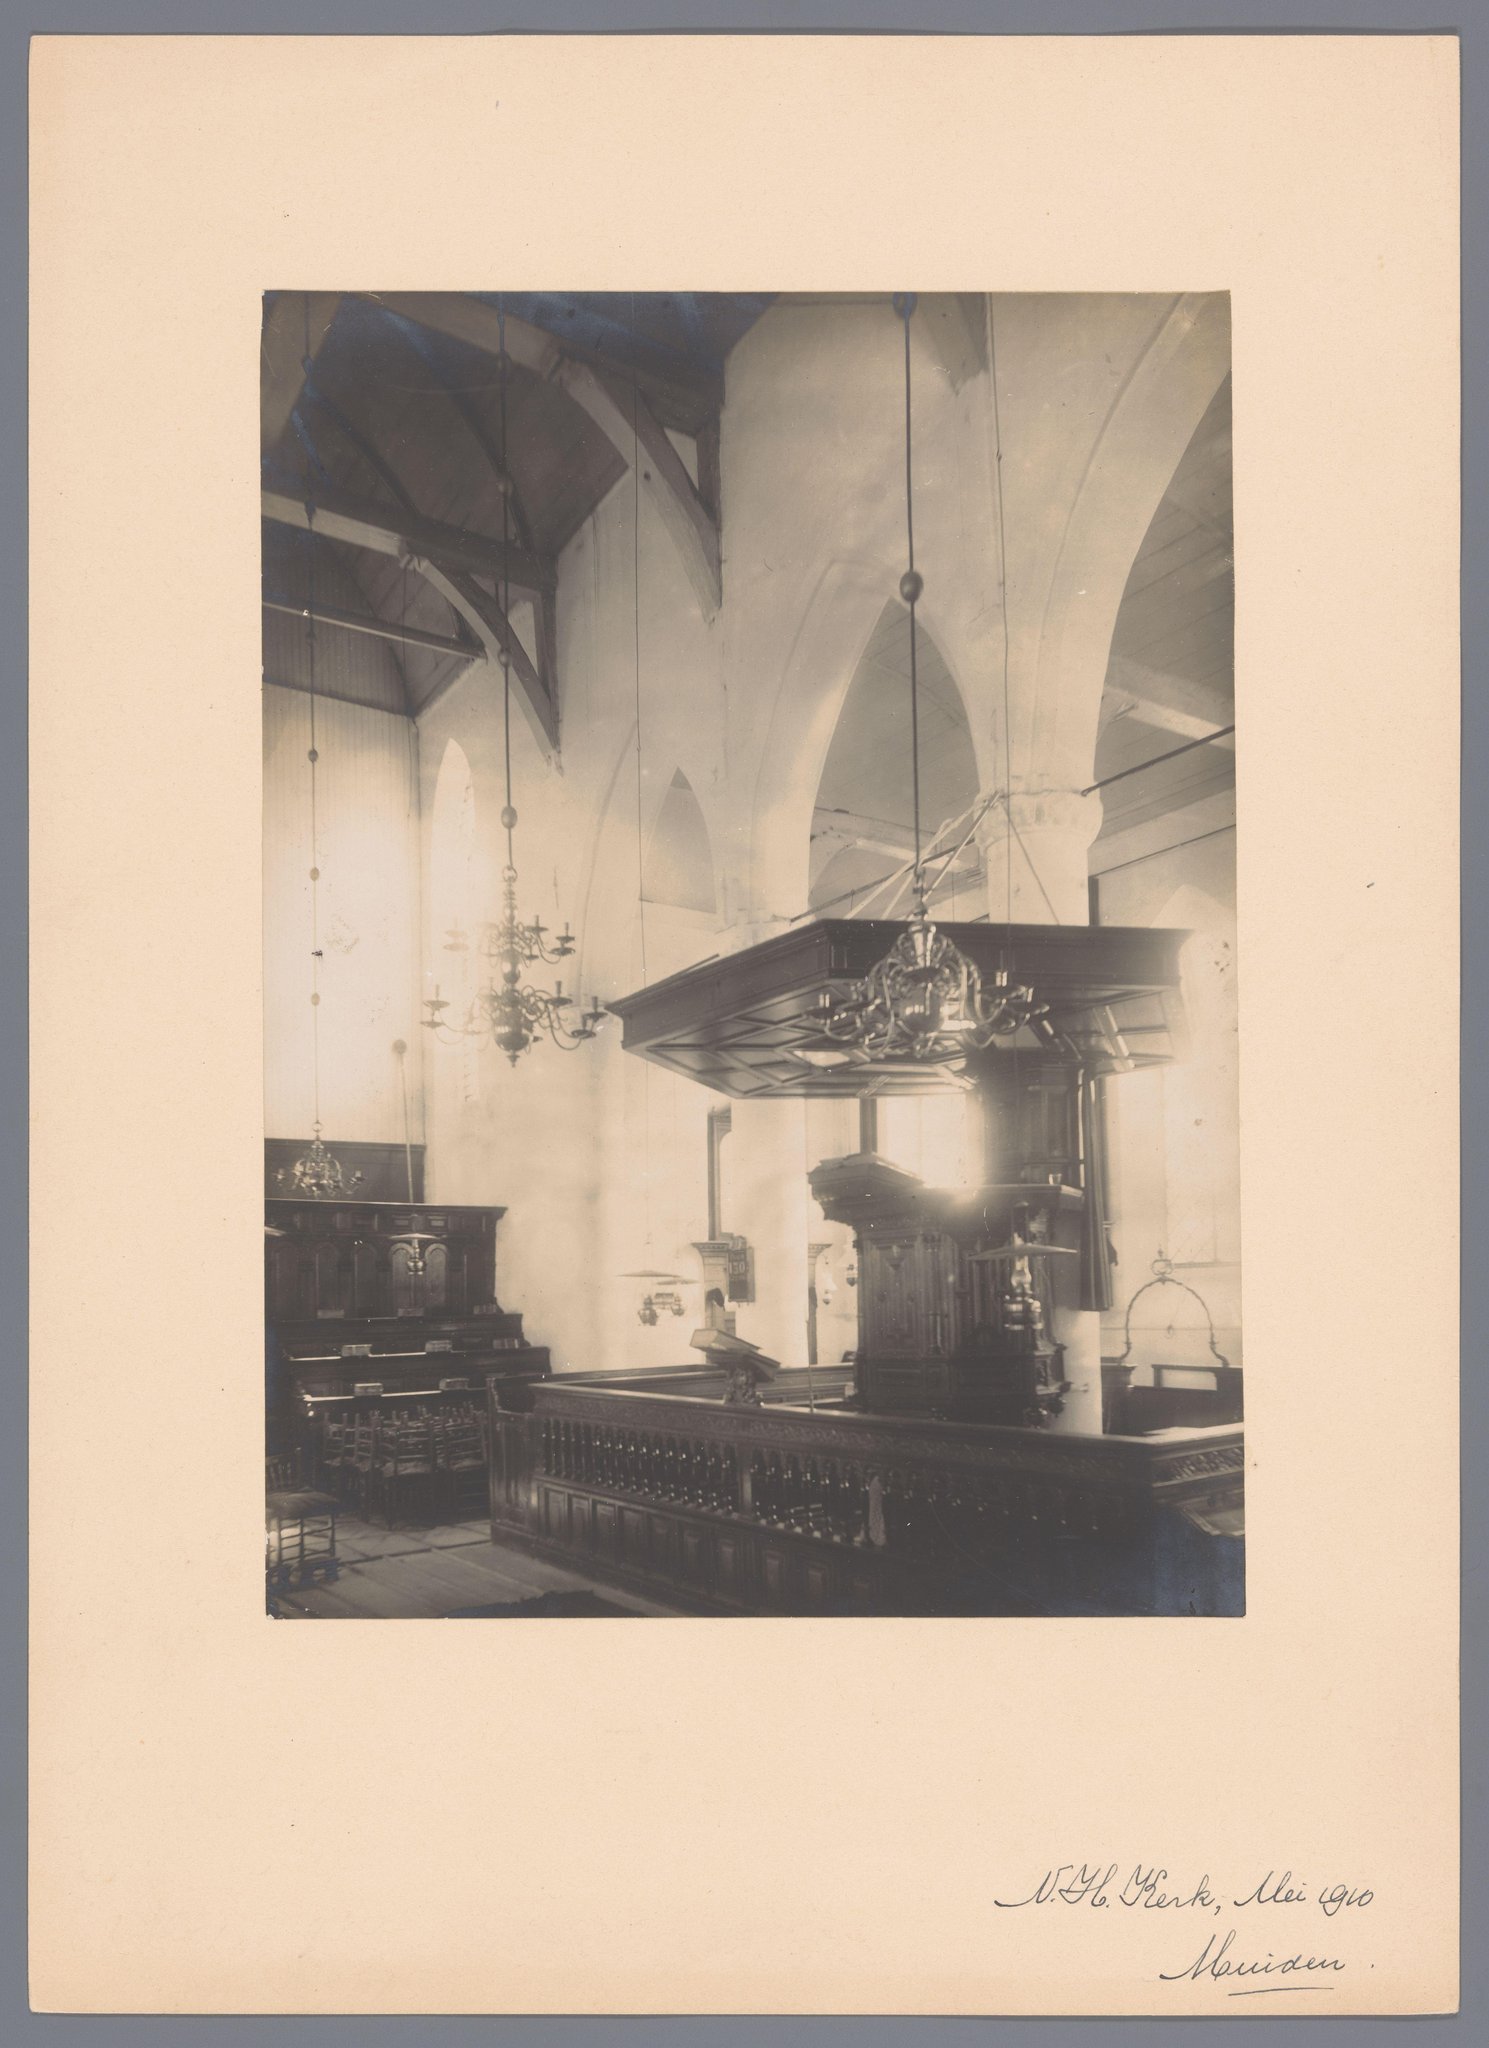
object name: photograph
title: Interieur van de Grote Kerk te Muiden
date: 1910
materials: cardboard, photographic support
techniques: gelatin silver print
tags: interior of church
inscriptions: annotation: ‘N.H. Kerk, Mei 1910/ Muiden’